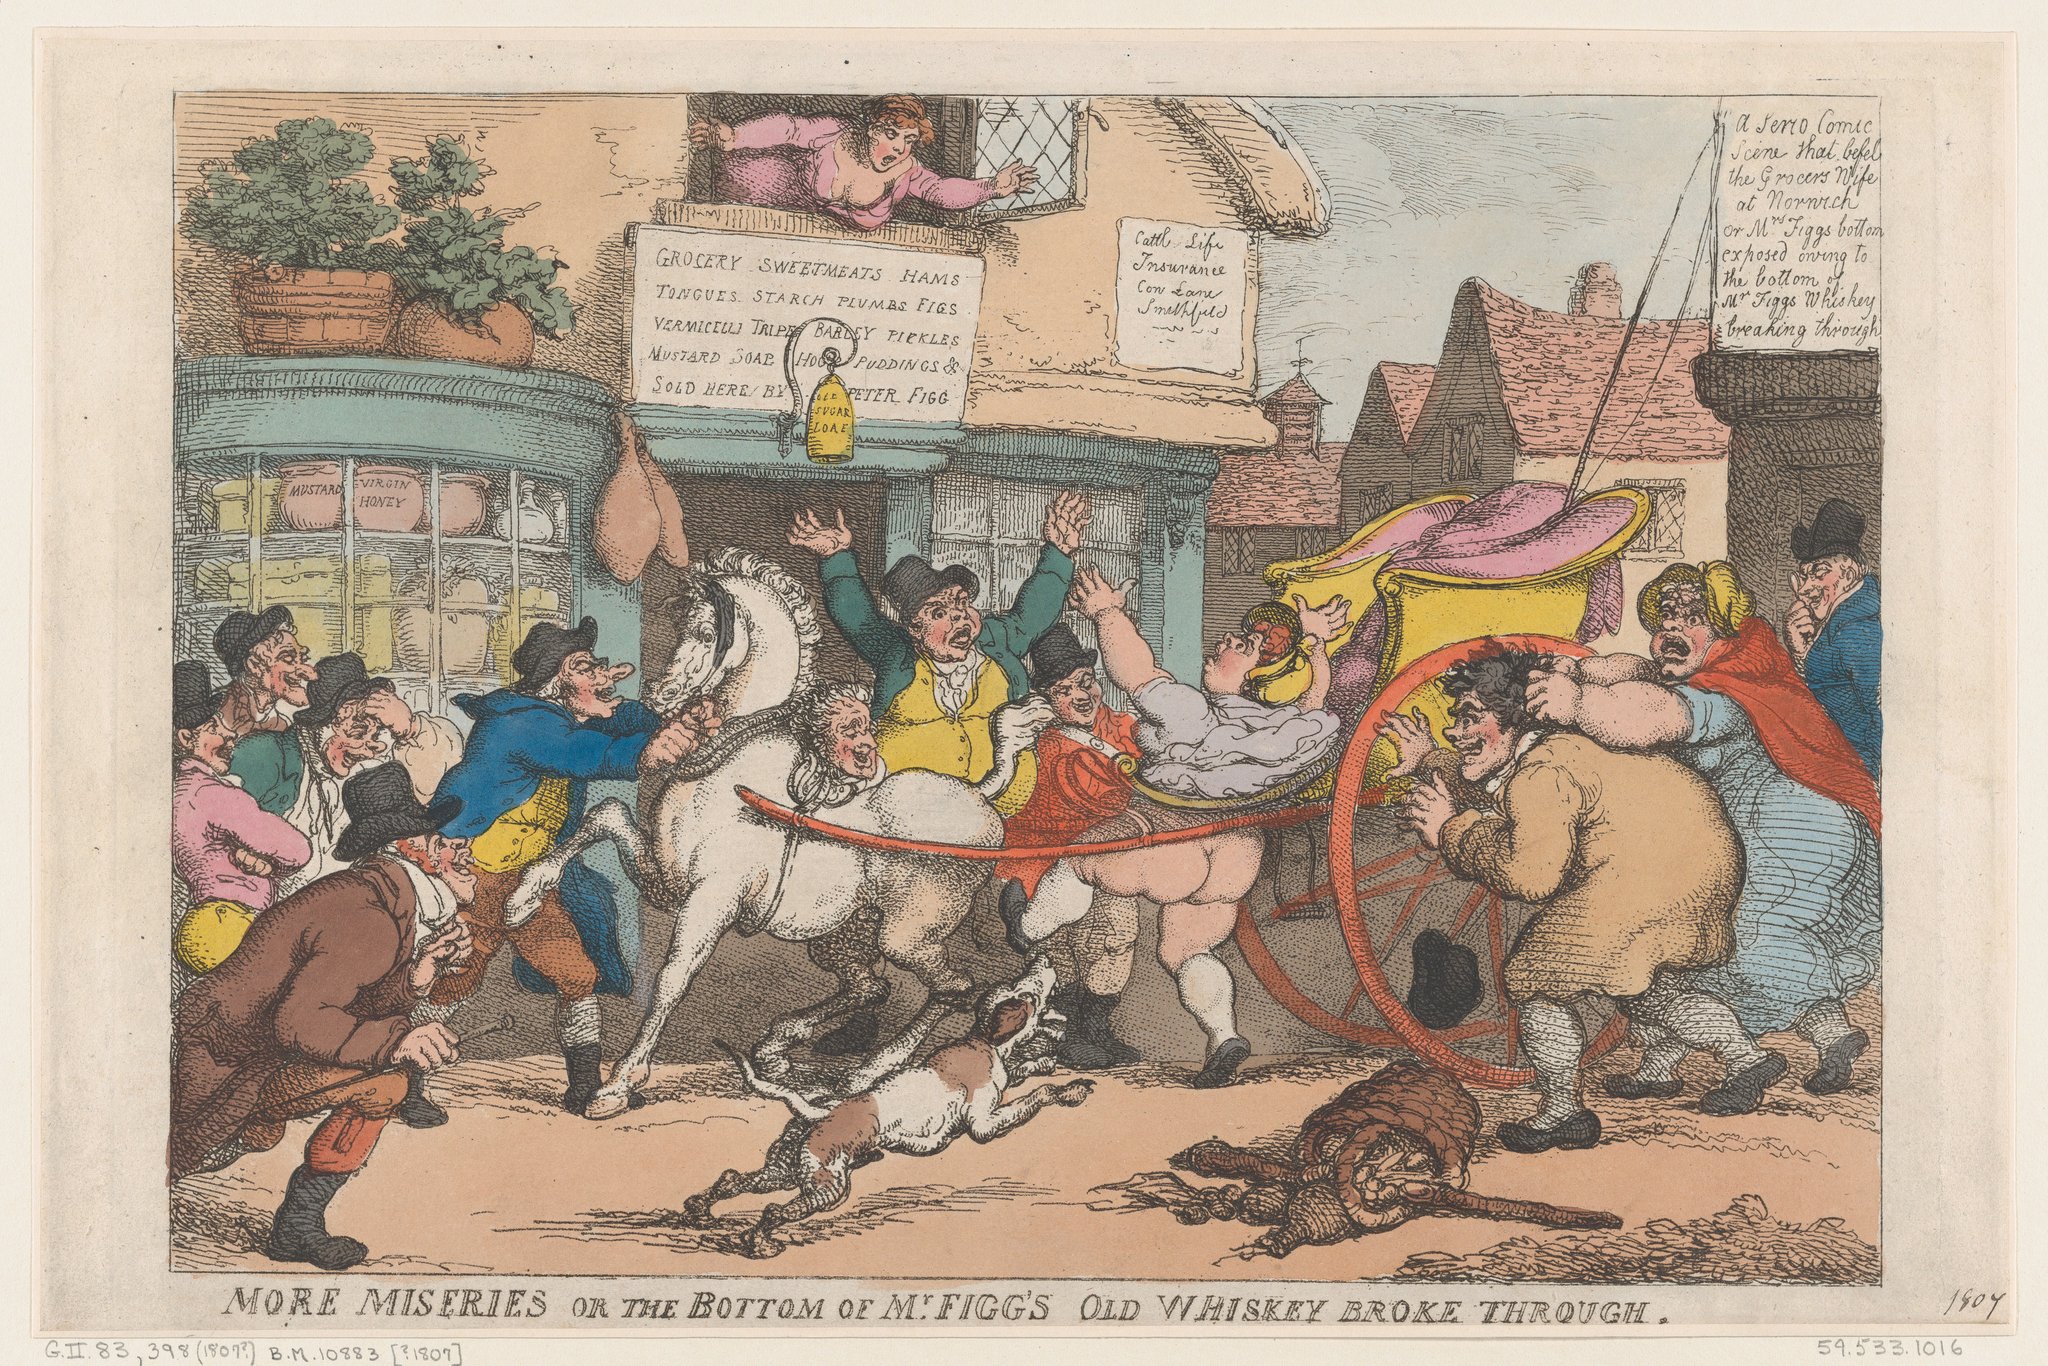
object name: print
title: More Miseries: The Bottom of Mr Figg's Old Whiskey Broke Through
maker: thomas rowlandson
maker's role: artist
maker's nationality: british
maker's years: 1757-1827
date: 1807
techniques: etching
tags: satire,men,women,dogs,horses,carriages